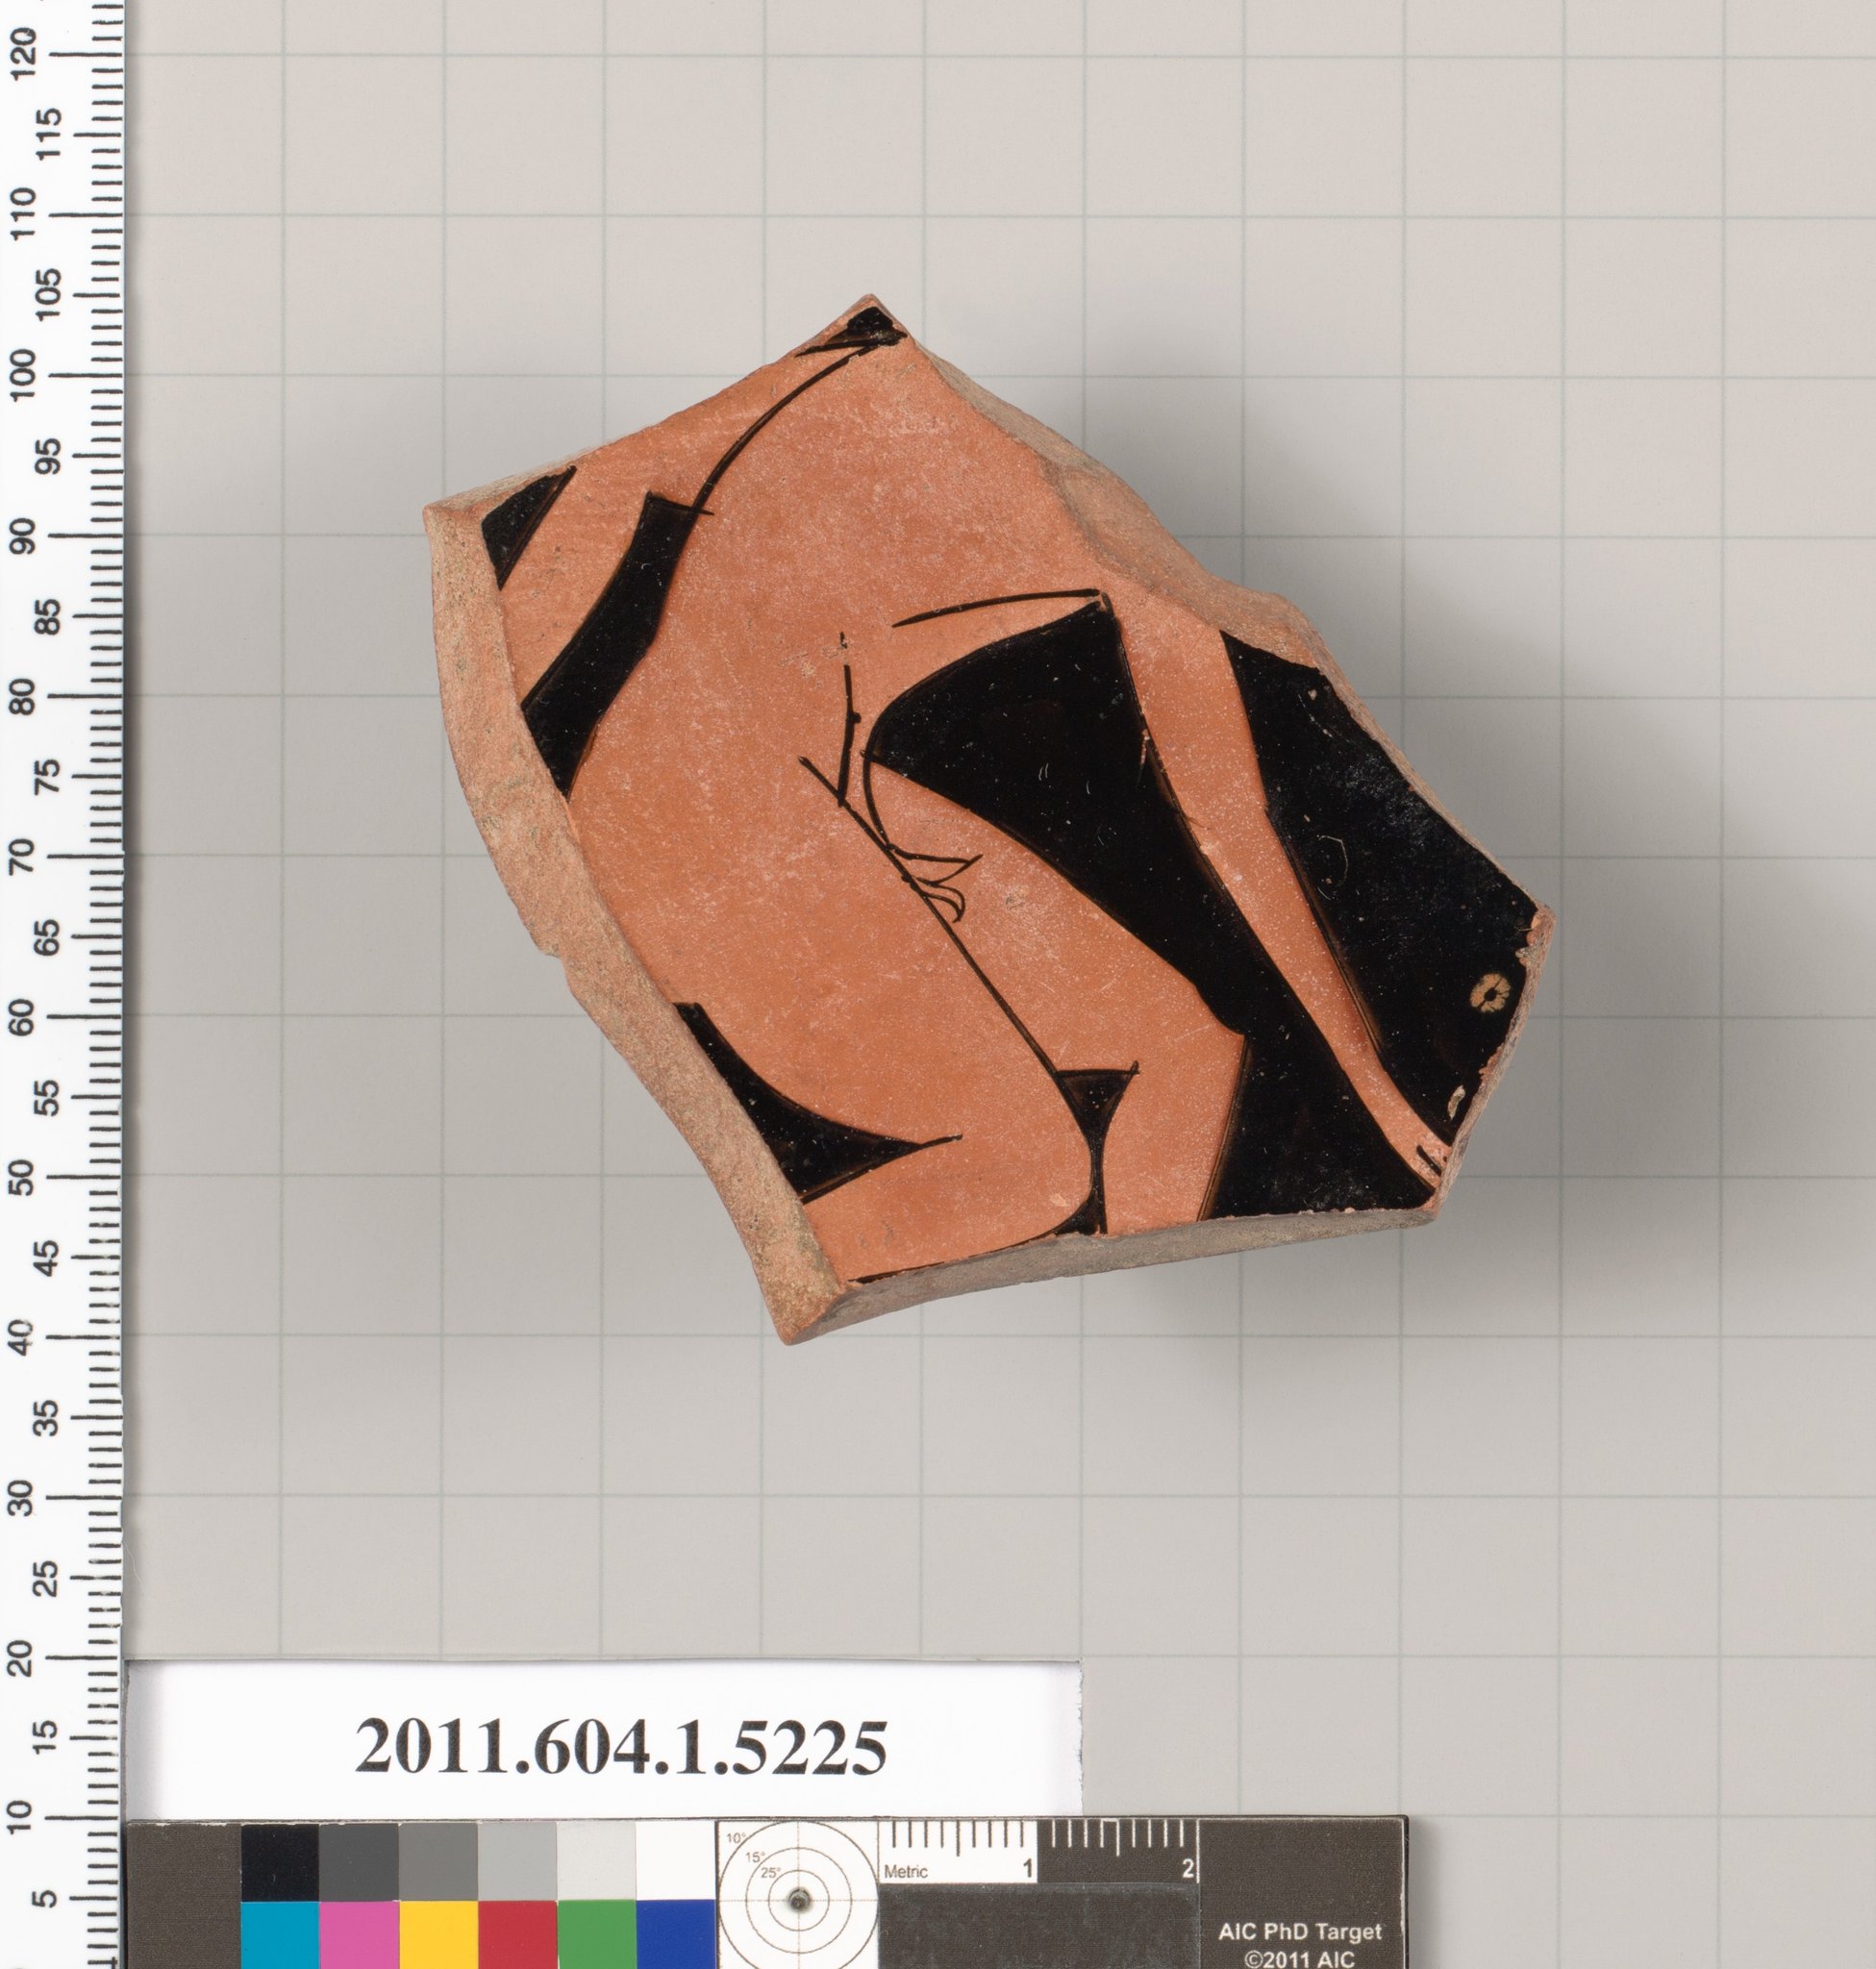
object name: kylix fragment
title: Terracotta fragment of a kylix (drinking cup)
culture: greek, attic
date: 520-500 BCE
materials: terracotta